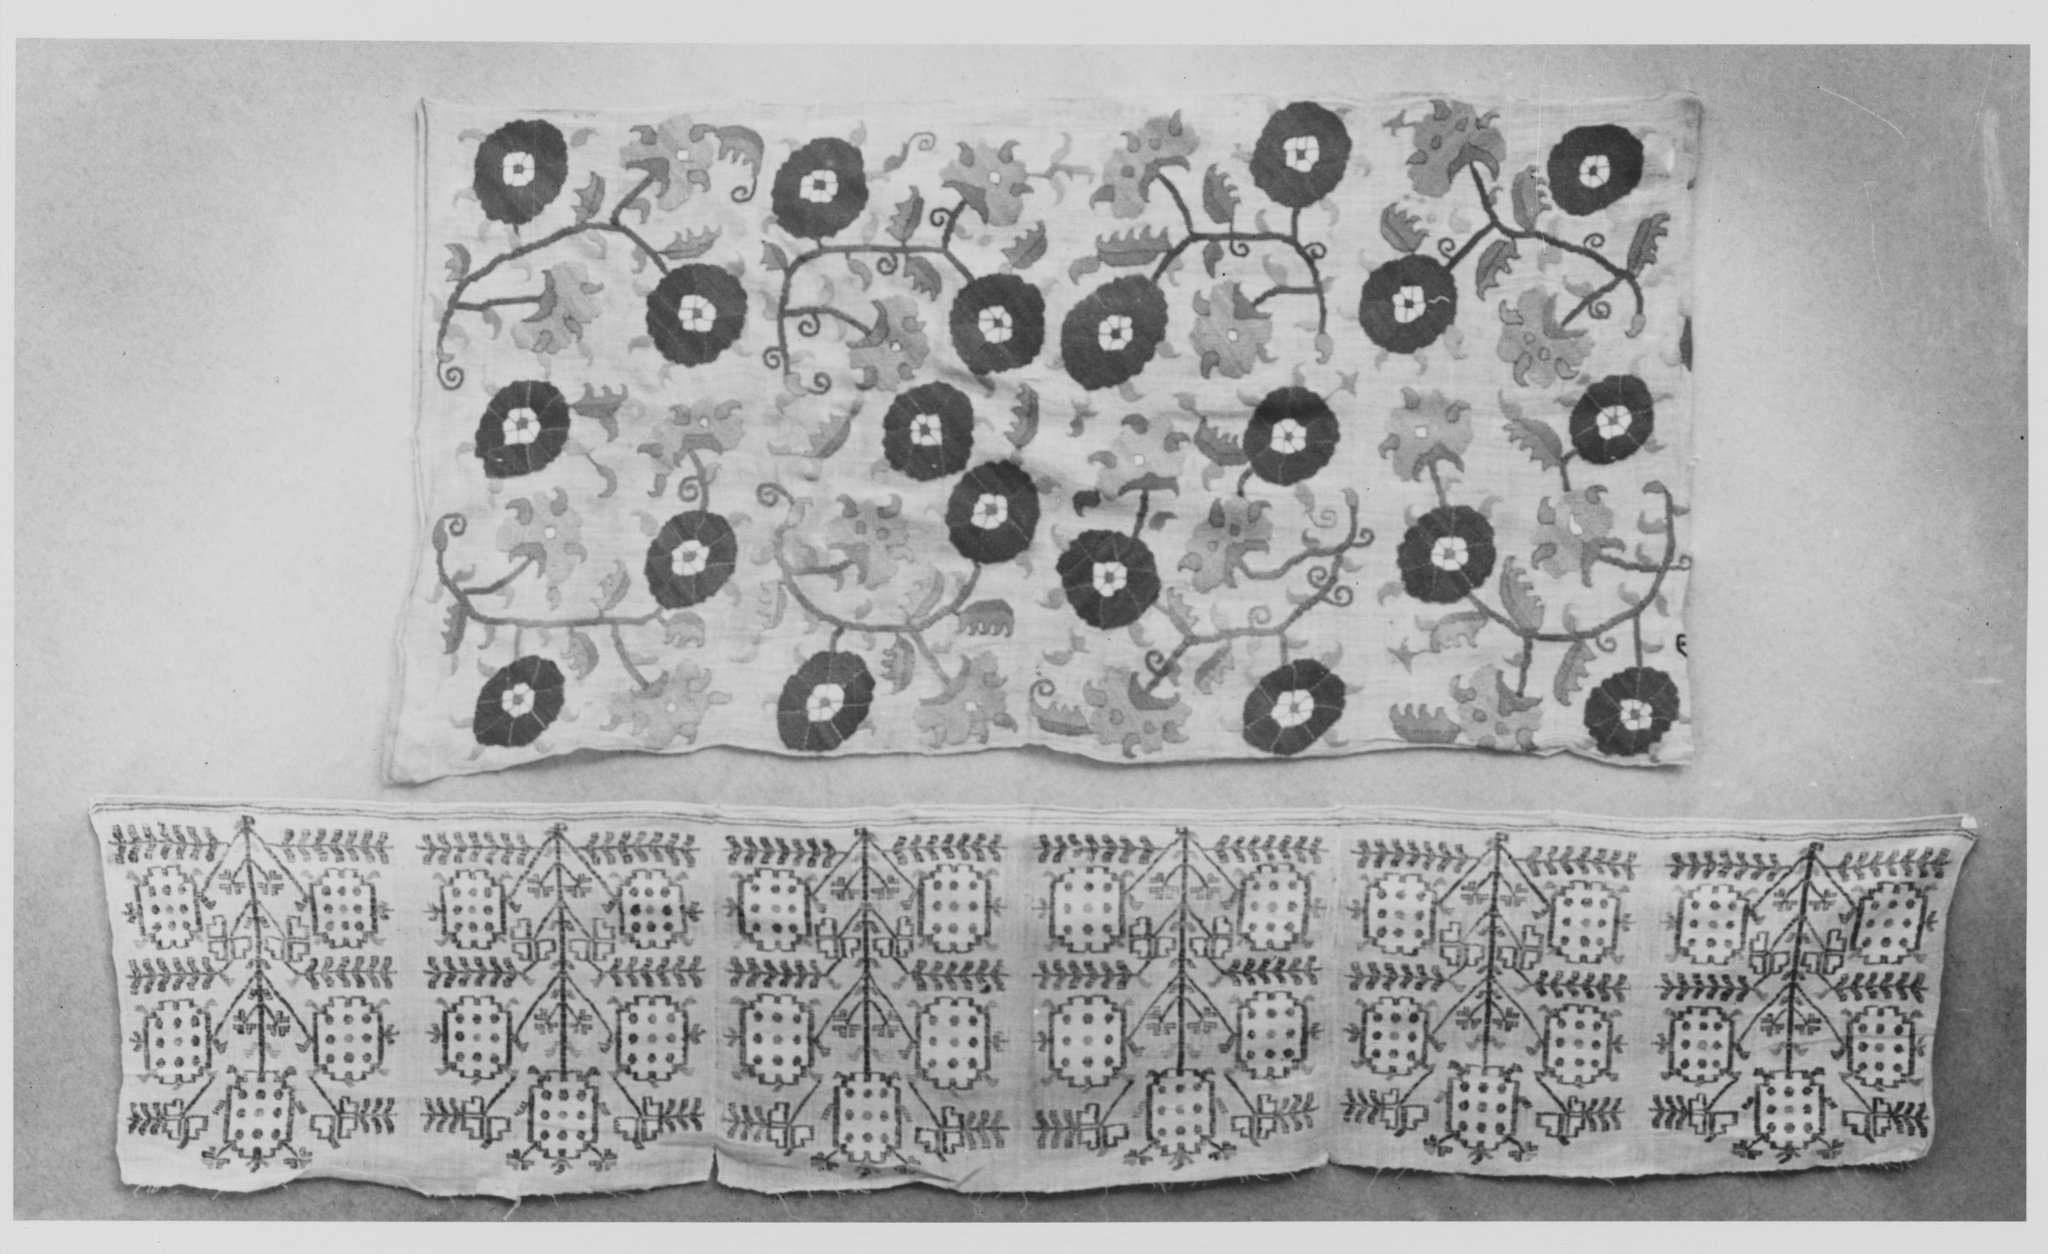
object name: textile fragment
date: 1801-1833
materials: linen, silk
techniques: embroidery, weave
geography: turkey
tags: flowers